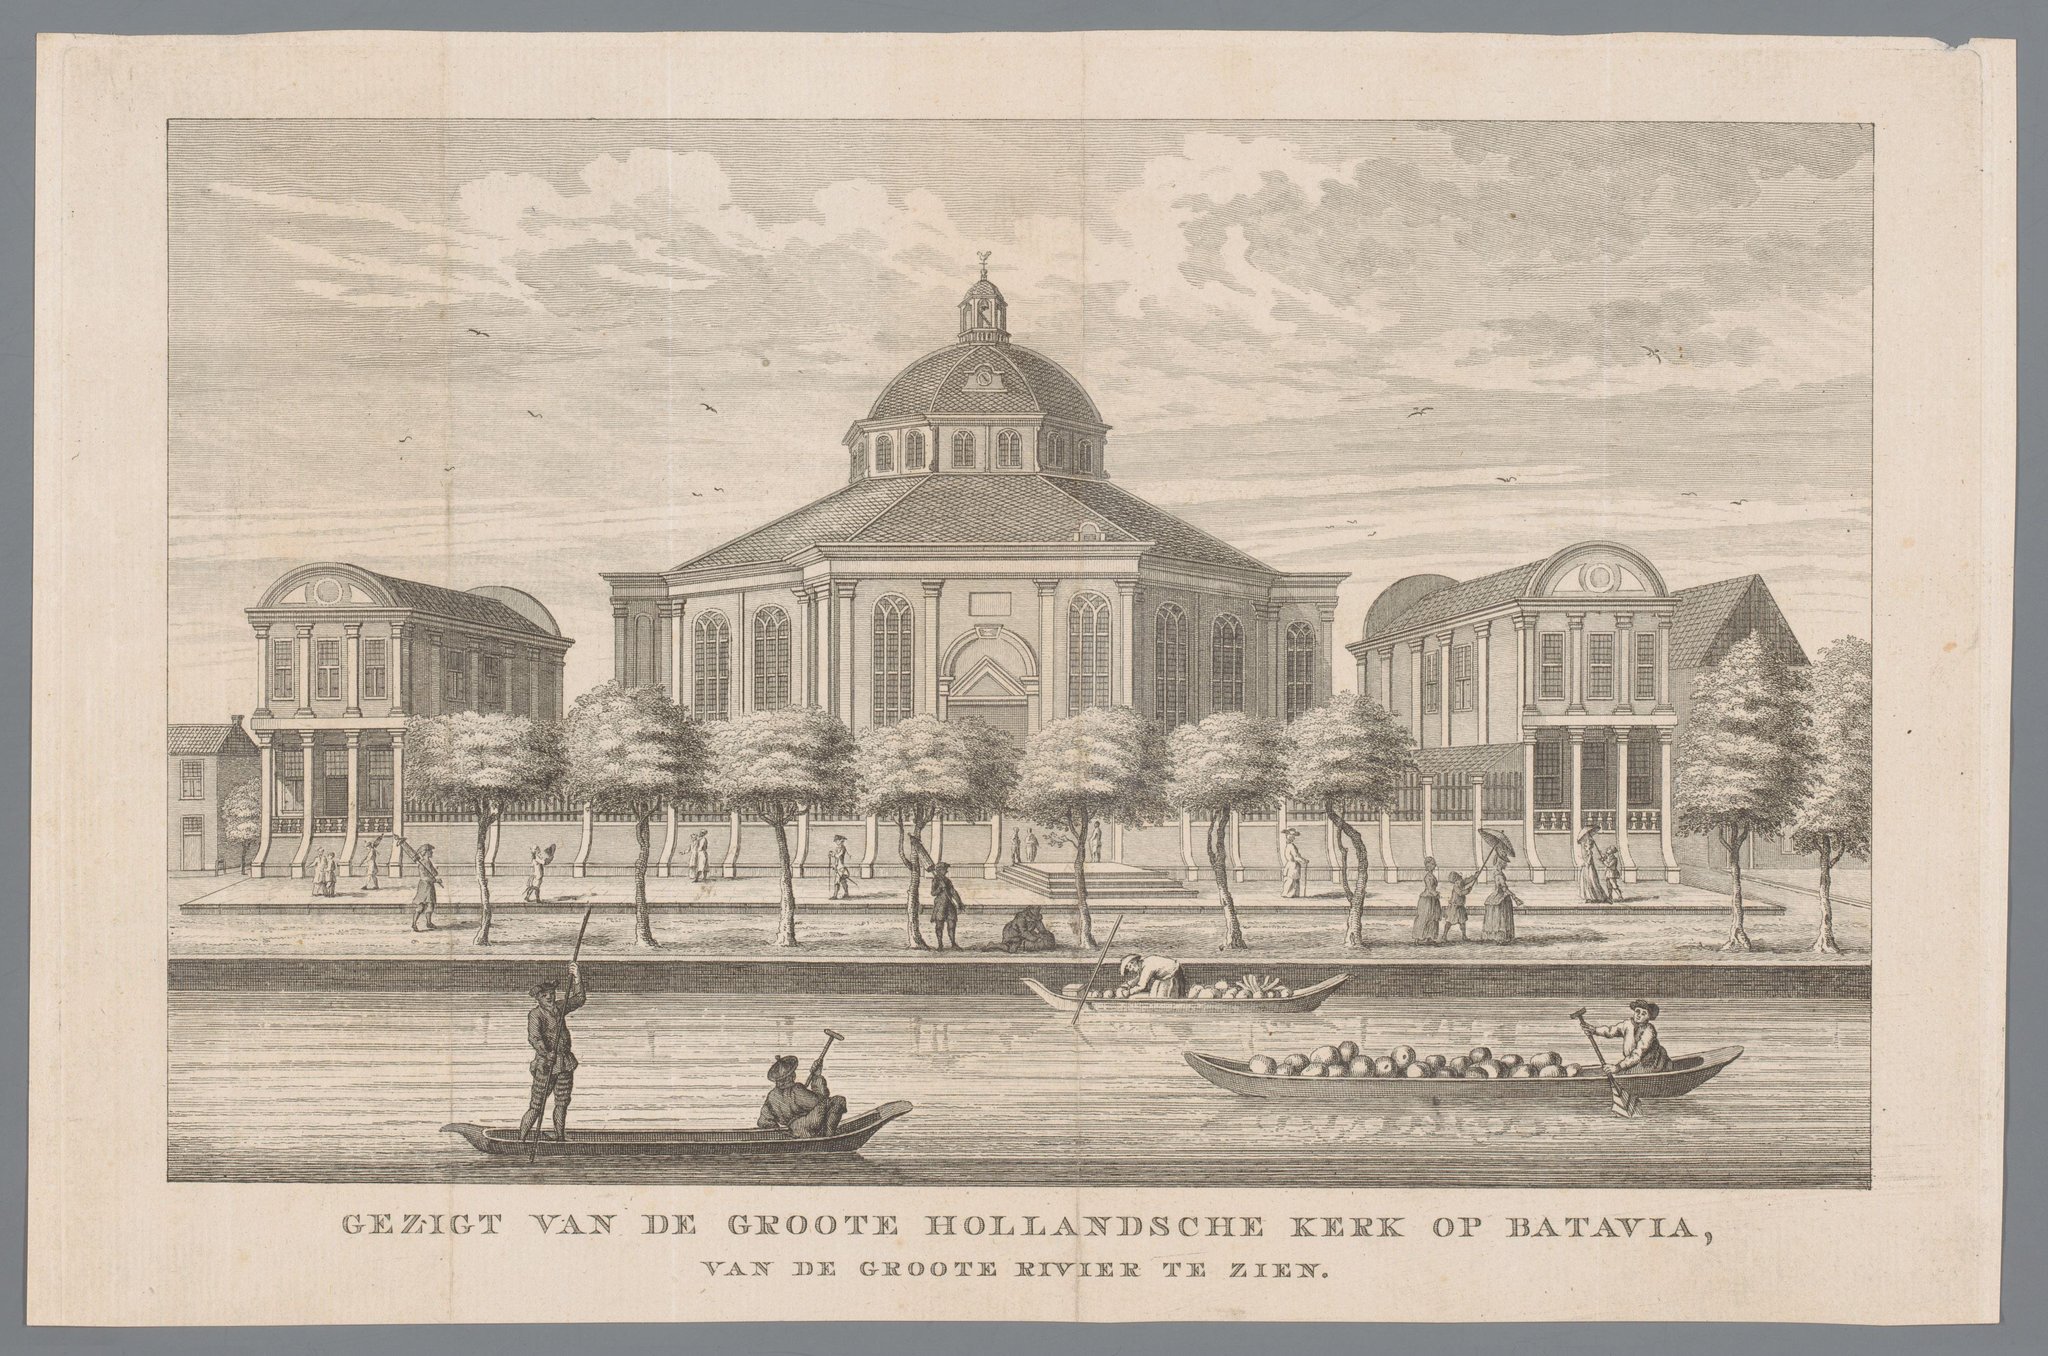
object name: book illustration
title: Gezicht op de Hollandse Kerk te Batavia vanaf de rivier gezien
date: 1781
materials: paper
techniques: engraving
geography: rotterdam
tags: church (exterior), batavia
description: Prent uit: Verhandelingen van het Bataviaasch Genootschap der Kunsten en Wetenschappen. 61 dln. Rotterdam en Amsterdam: Reinier Arrenberg en Johannes Allart, 1781, dl. 1, p. 49.